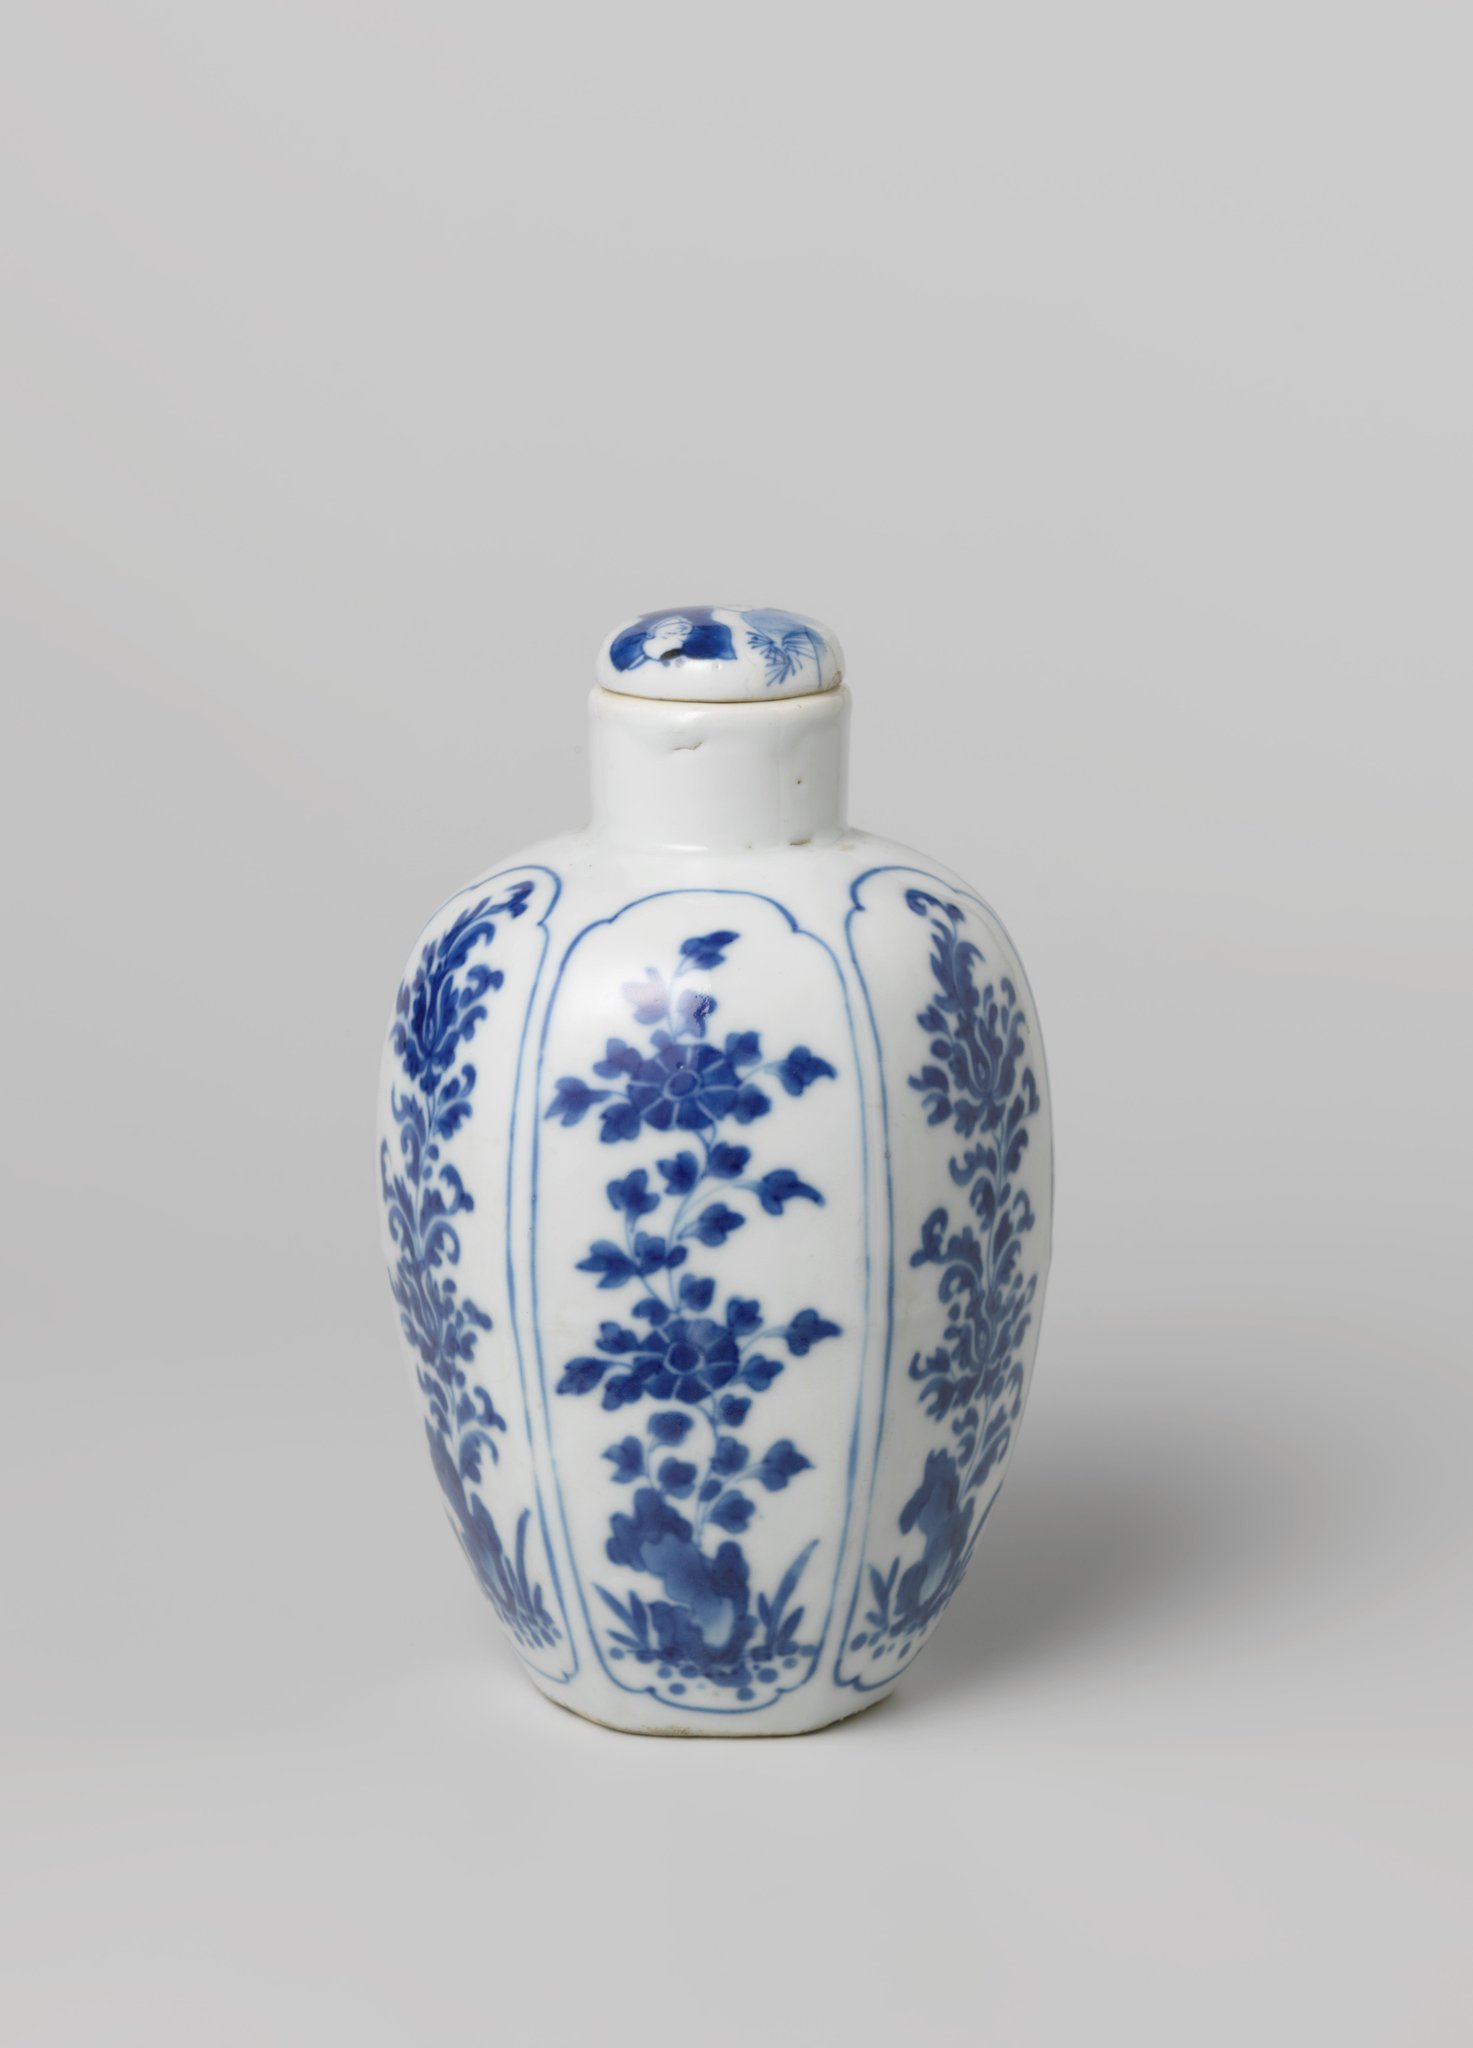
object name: covered jar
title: Ovoid covered jar with flowering plants in panels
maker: Anonymous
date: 1700-1724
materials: cobalt, glaze, paint, porcelain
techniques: firing, turning, vitrification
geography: china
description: Deksel van eivormige dekselpot van porselein, beschilderd in onderglazuur blauw. Op de deksel met een dansende jongen (zotje) in een landschap. Deksel is niet bijpassend. Blauw-wit.